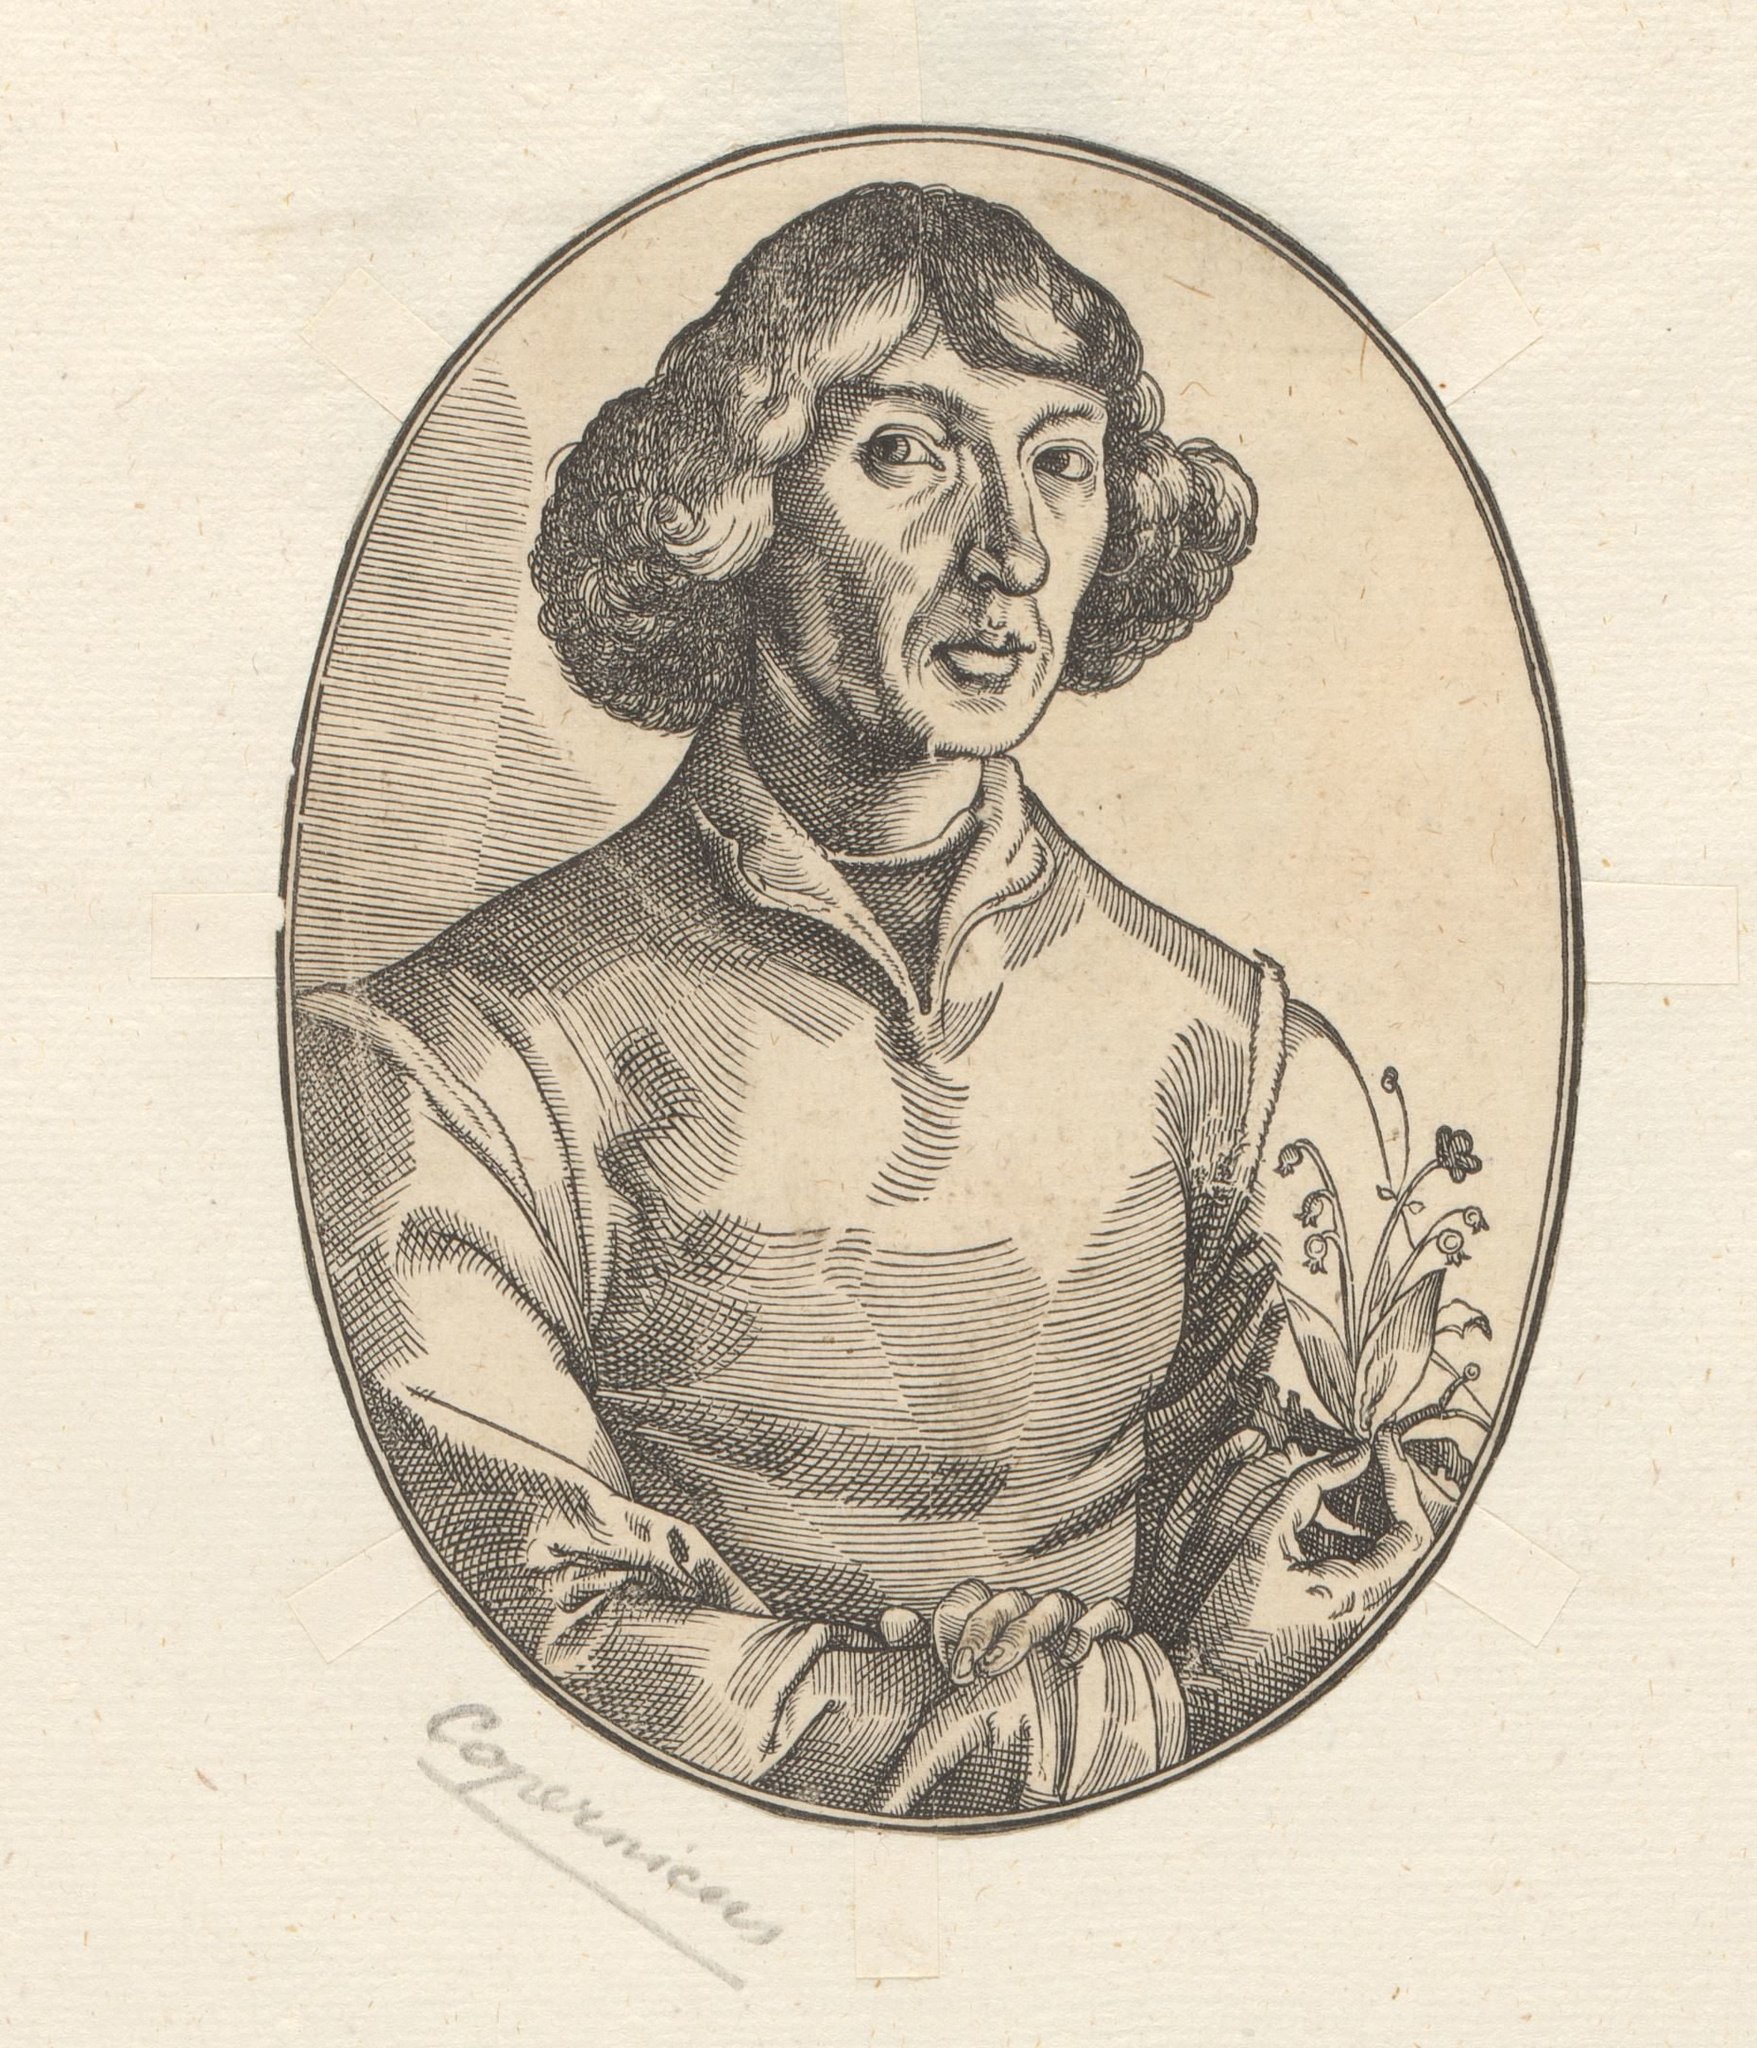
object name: print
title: Portret van Nicolaus Copernicus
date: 1549-1584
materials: paper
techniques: woodcut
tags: astronomy (and cosmography) (+ portrait of scholar, scientist), historical persons, scholar, philosopher (+ portrait of scholar, scientist)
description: Prent gebruikt in: Reusner, Nikolaus. Icones Sive Imagines Vivae (...). Straatsburg: Bernhard Jobin, 1587